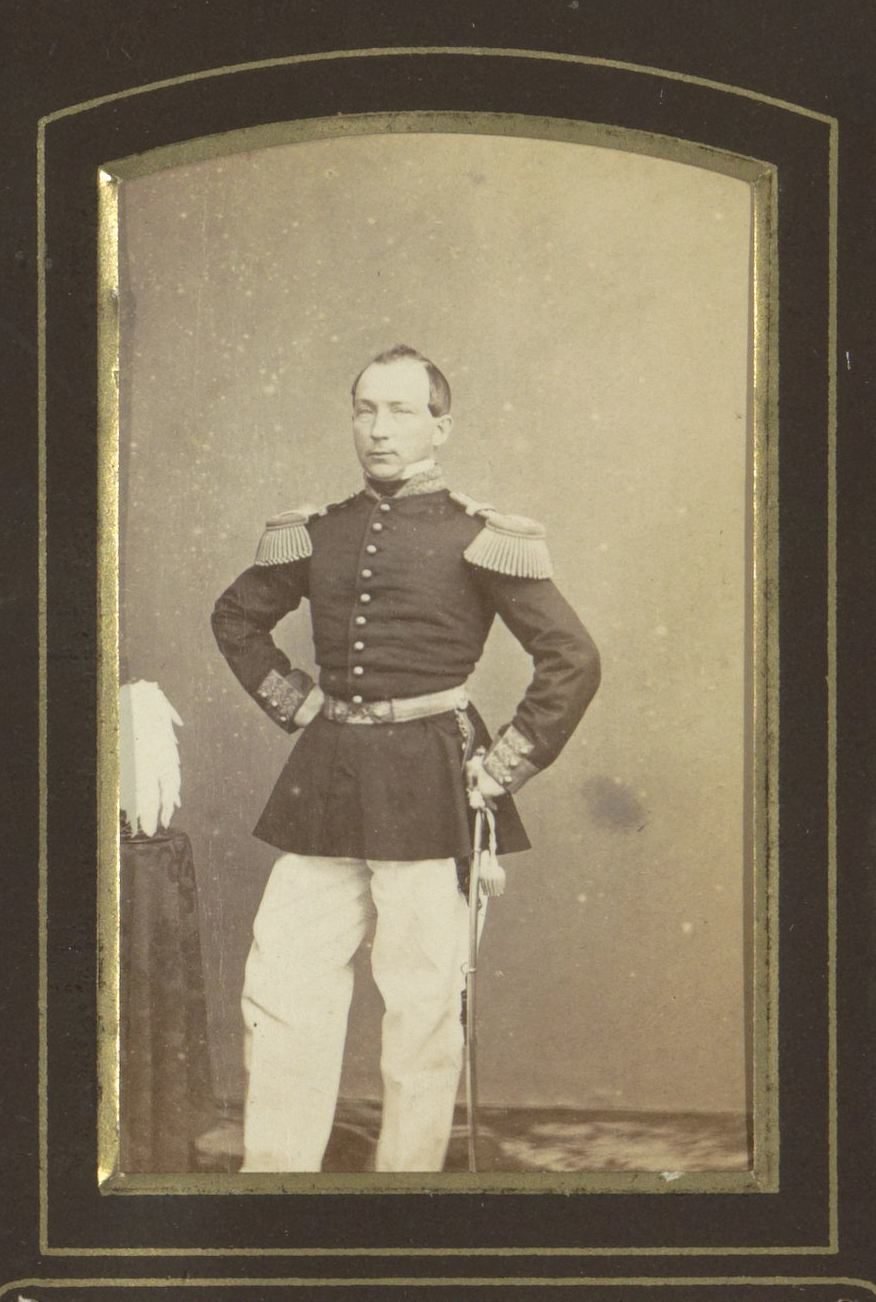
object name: photograph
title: Portret van de latere Generaal-Majoor G.B.T. Wiggers van Kerchem op jonge leeftijd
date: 1857-1865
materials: cardboard, paper, photographic support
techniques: albumen print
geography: java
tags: adult man, historical persons, (military) uniforms, java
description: Onderdeel van Fotoalbum van de families Matthes, Doorman en Van Thiel.